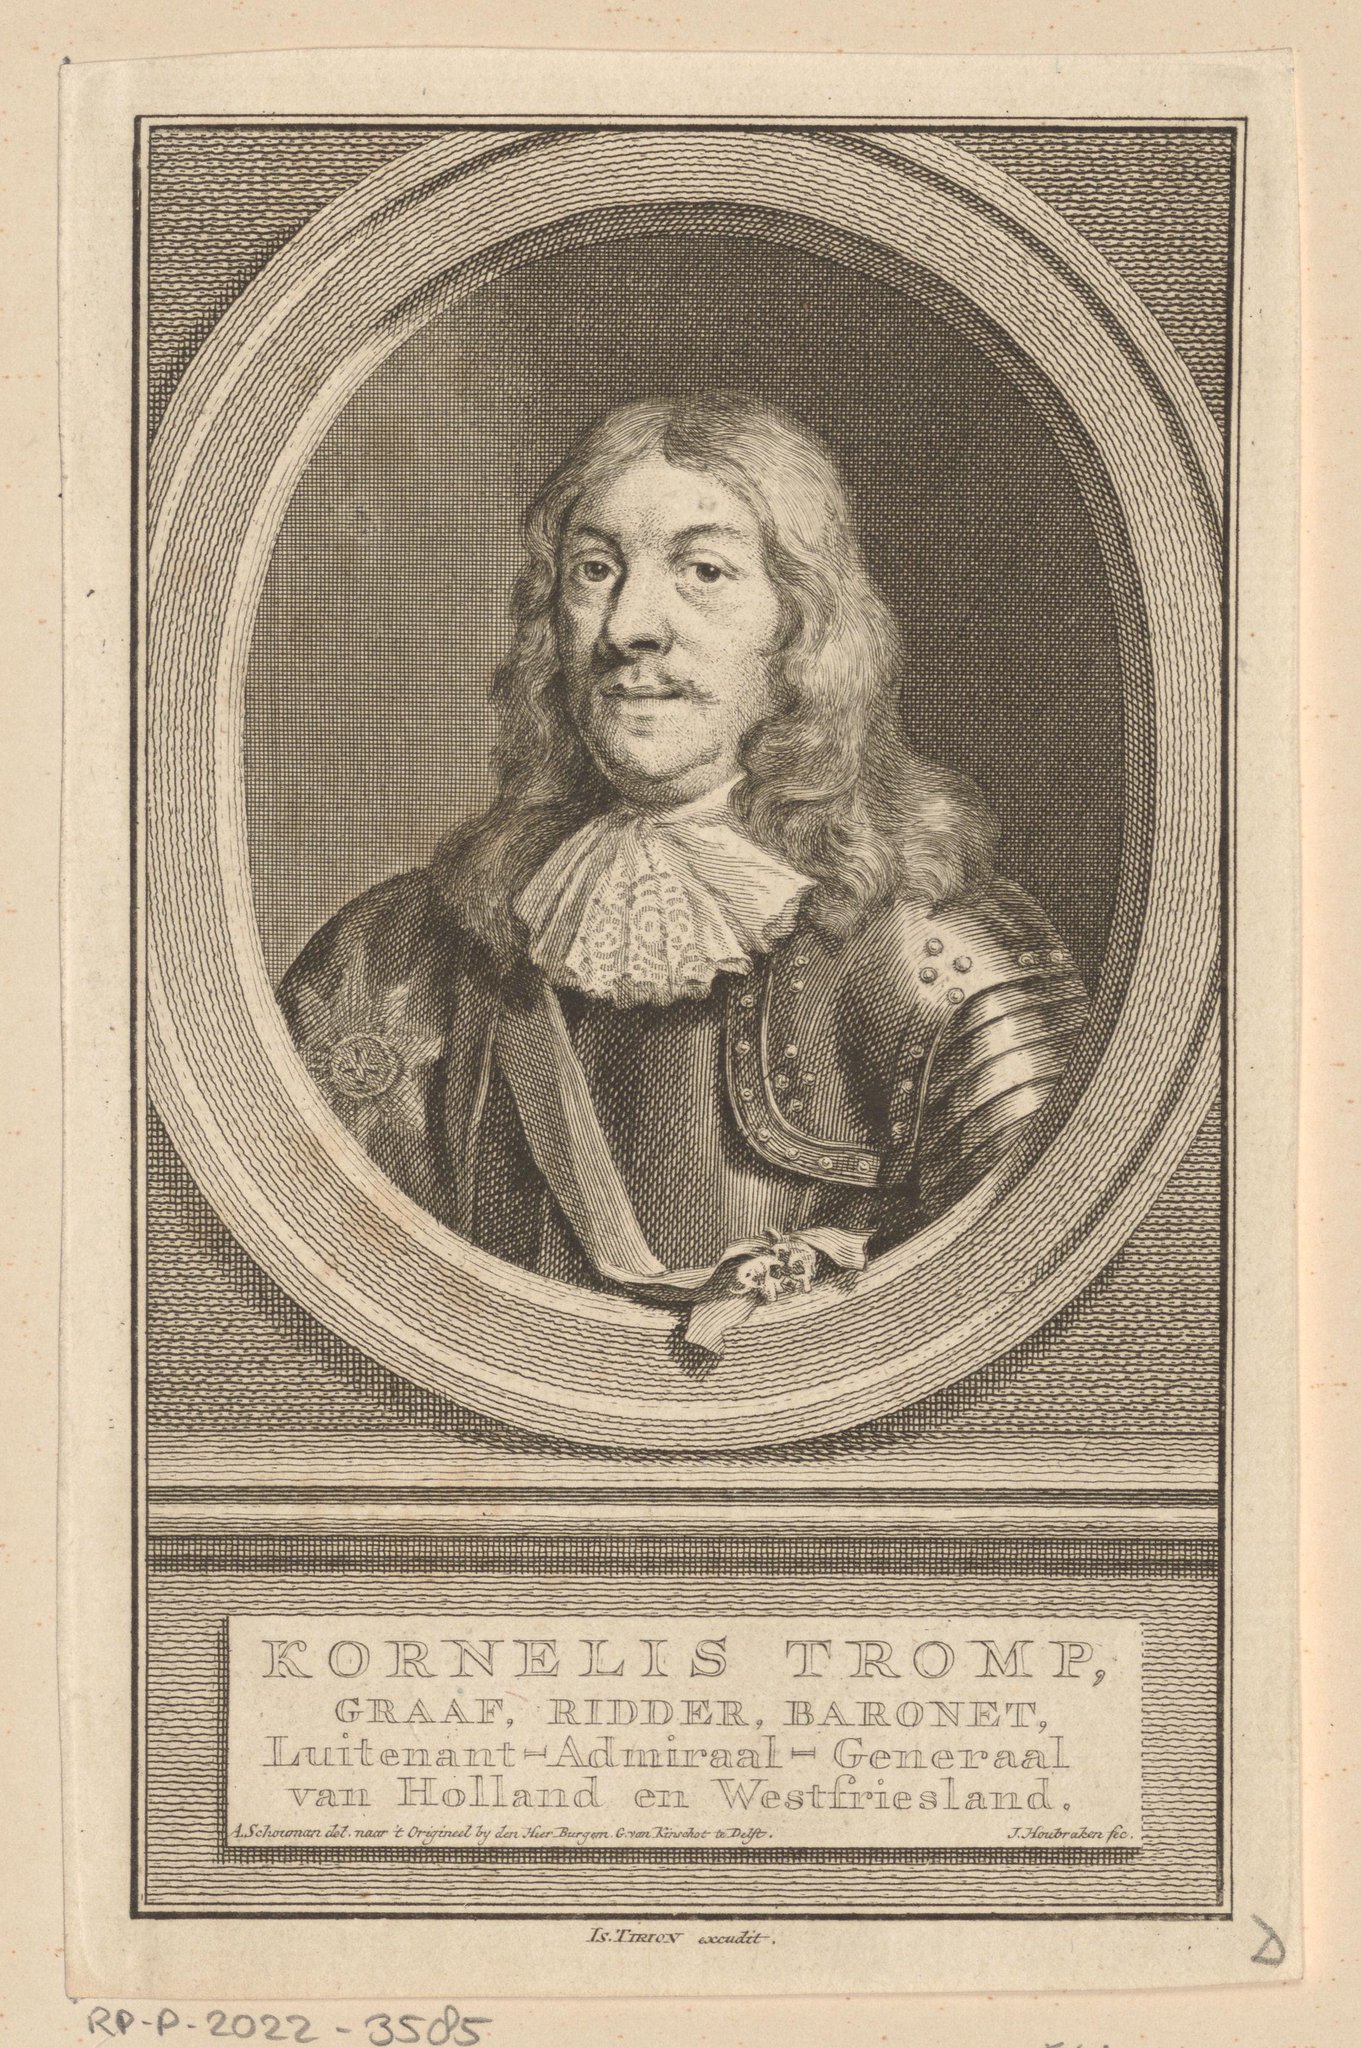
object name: print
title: Portret van Cornelis Tromp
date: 1757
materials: paper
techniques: engraving, etching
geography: amsterdam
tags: rotterdam, cornelis tromp, armour, historical persons, commander-in-chief, admiral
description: Prent waarschijnlijk uit: Wagenaar, Jan. Vaderlandsche historie, vervattende de geschiedenissen der nu Vereenigde Nederlanden, inzonderheid die van Holland (...), Amsterdam, Isaak Tirion, 1757, dl 16, p. 150.